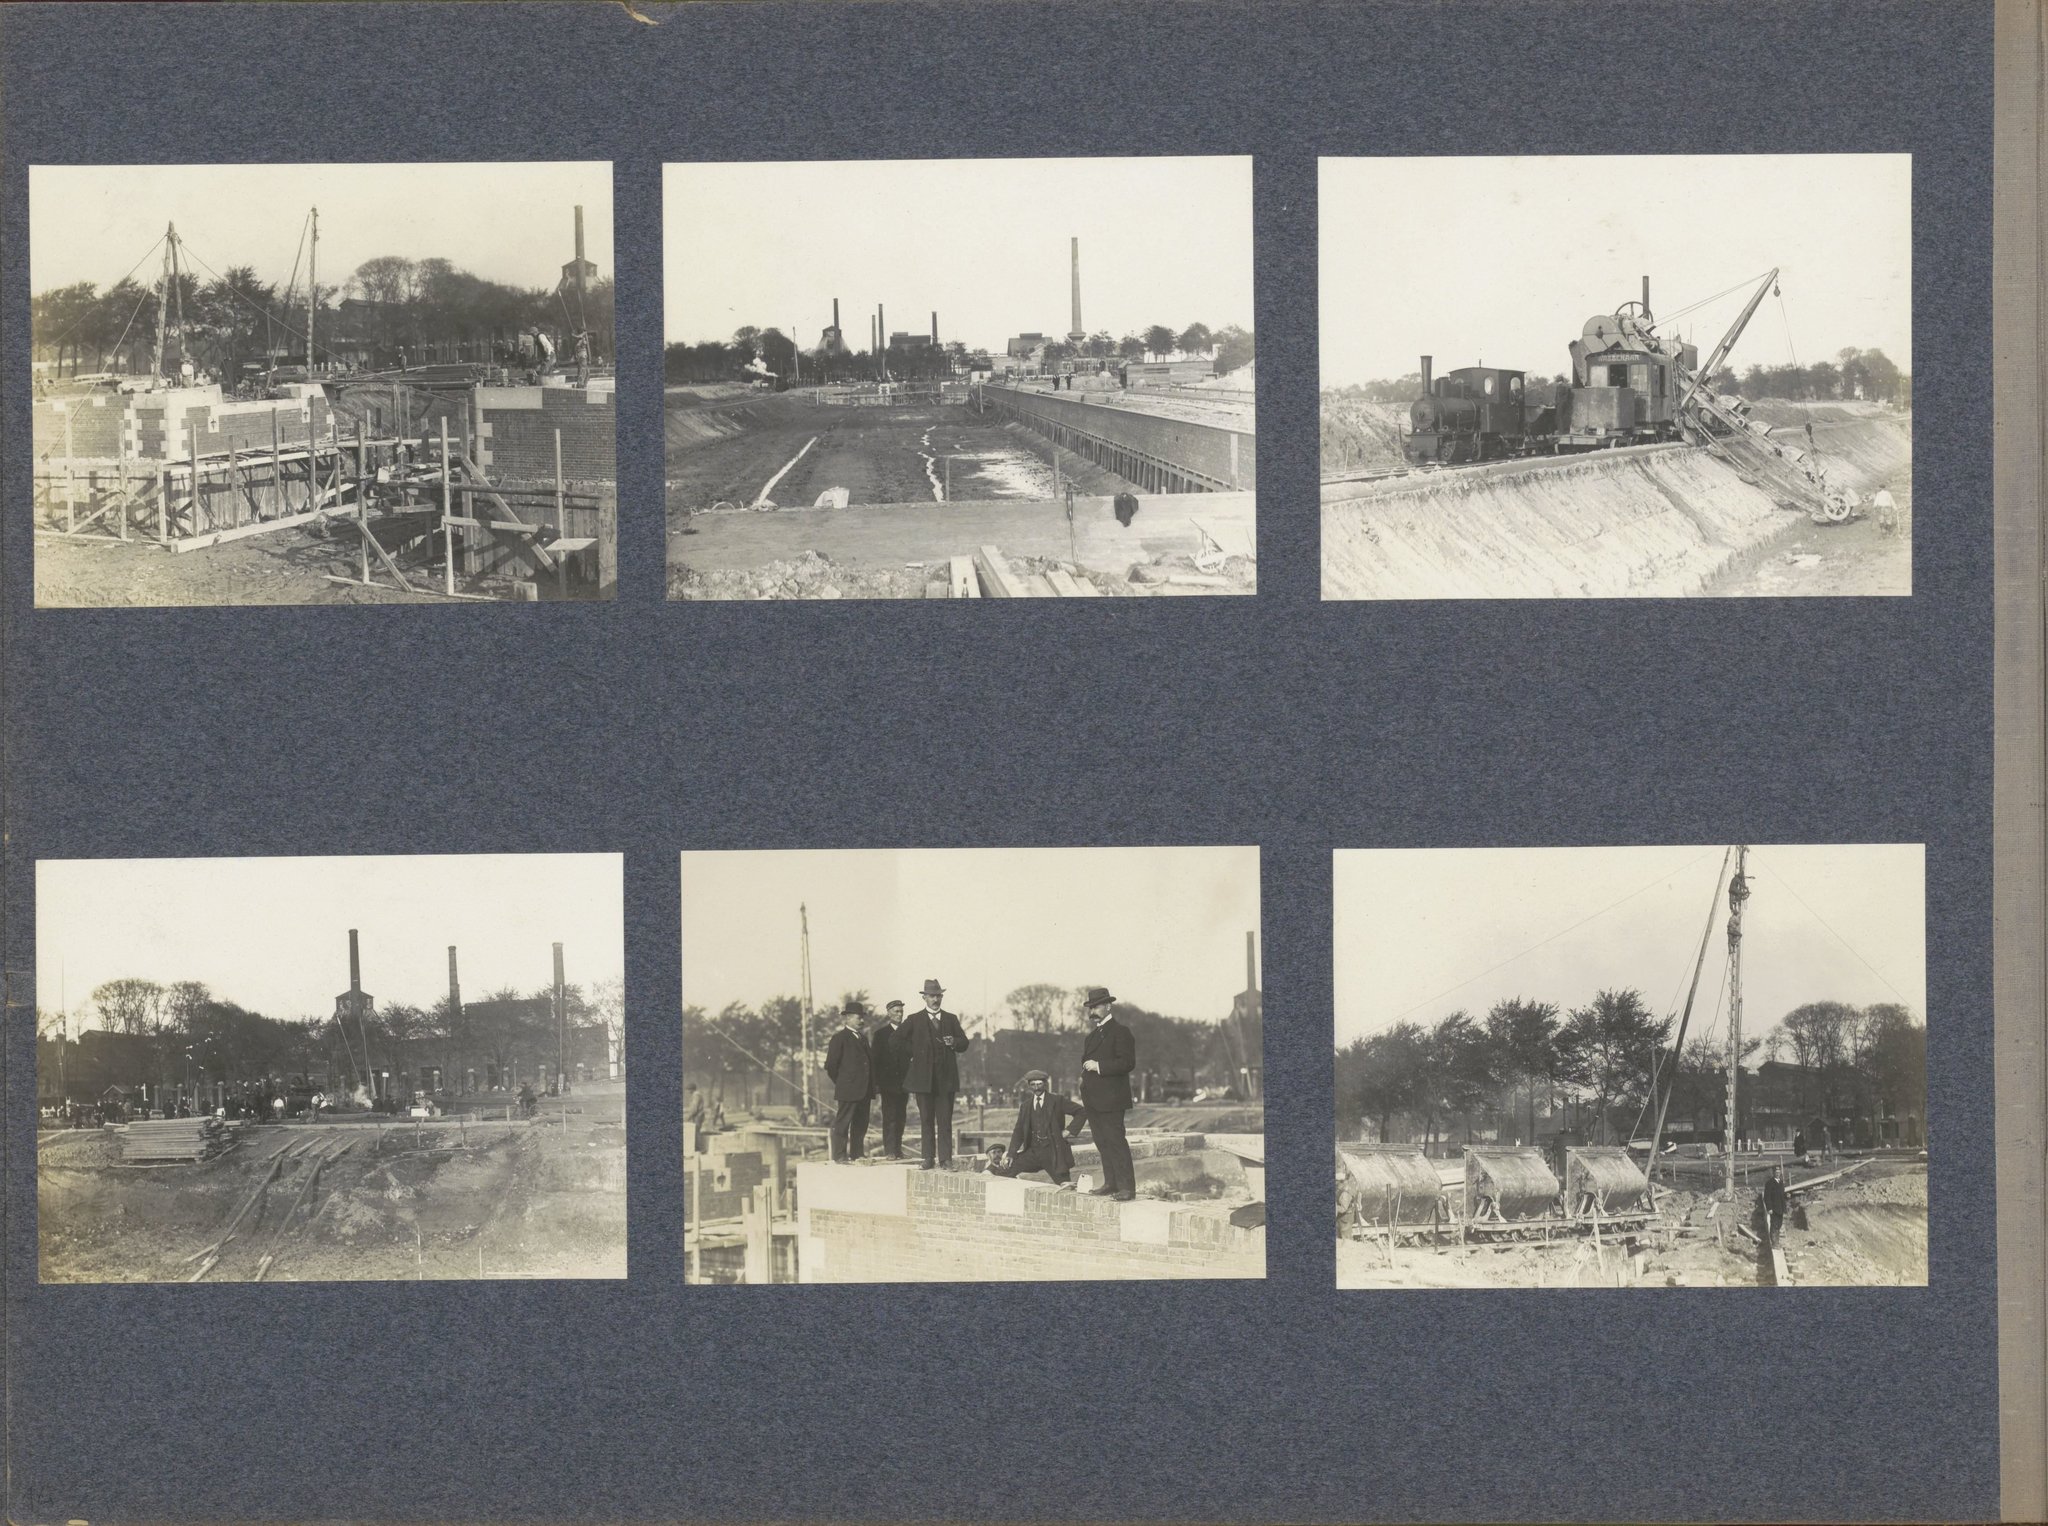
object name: photograph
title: Aanleg van een waterwerk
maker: Anonymous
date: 1910-1911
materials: cardboard, paper, photographic support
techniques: gelatin silver print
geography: netherlands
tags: sluice, weir, machines; parts of machines; tools and appliances, canal, netherlands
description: Albumblad met zes foto's van de aanleg van een waterwerk (mogelijk een kanaal met sluis) in de buurt van een fabrieksterrein. Afgebeeld zijn graafmachines en graafwerkzaamheden, het tracé, steigers, muren in aanbouw en een groep mannen die de werkzaamheden bekijken. Onderdeel van Fotoalbum van de familie Palthe uit Almelo.